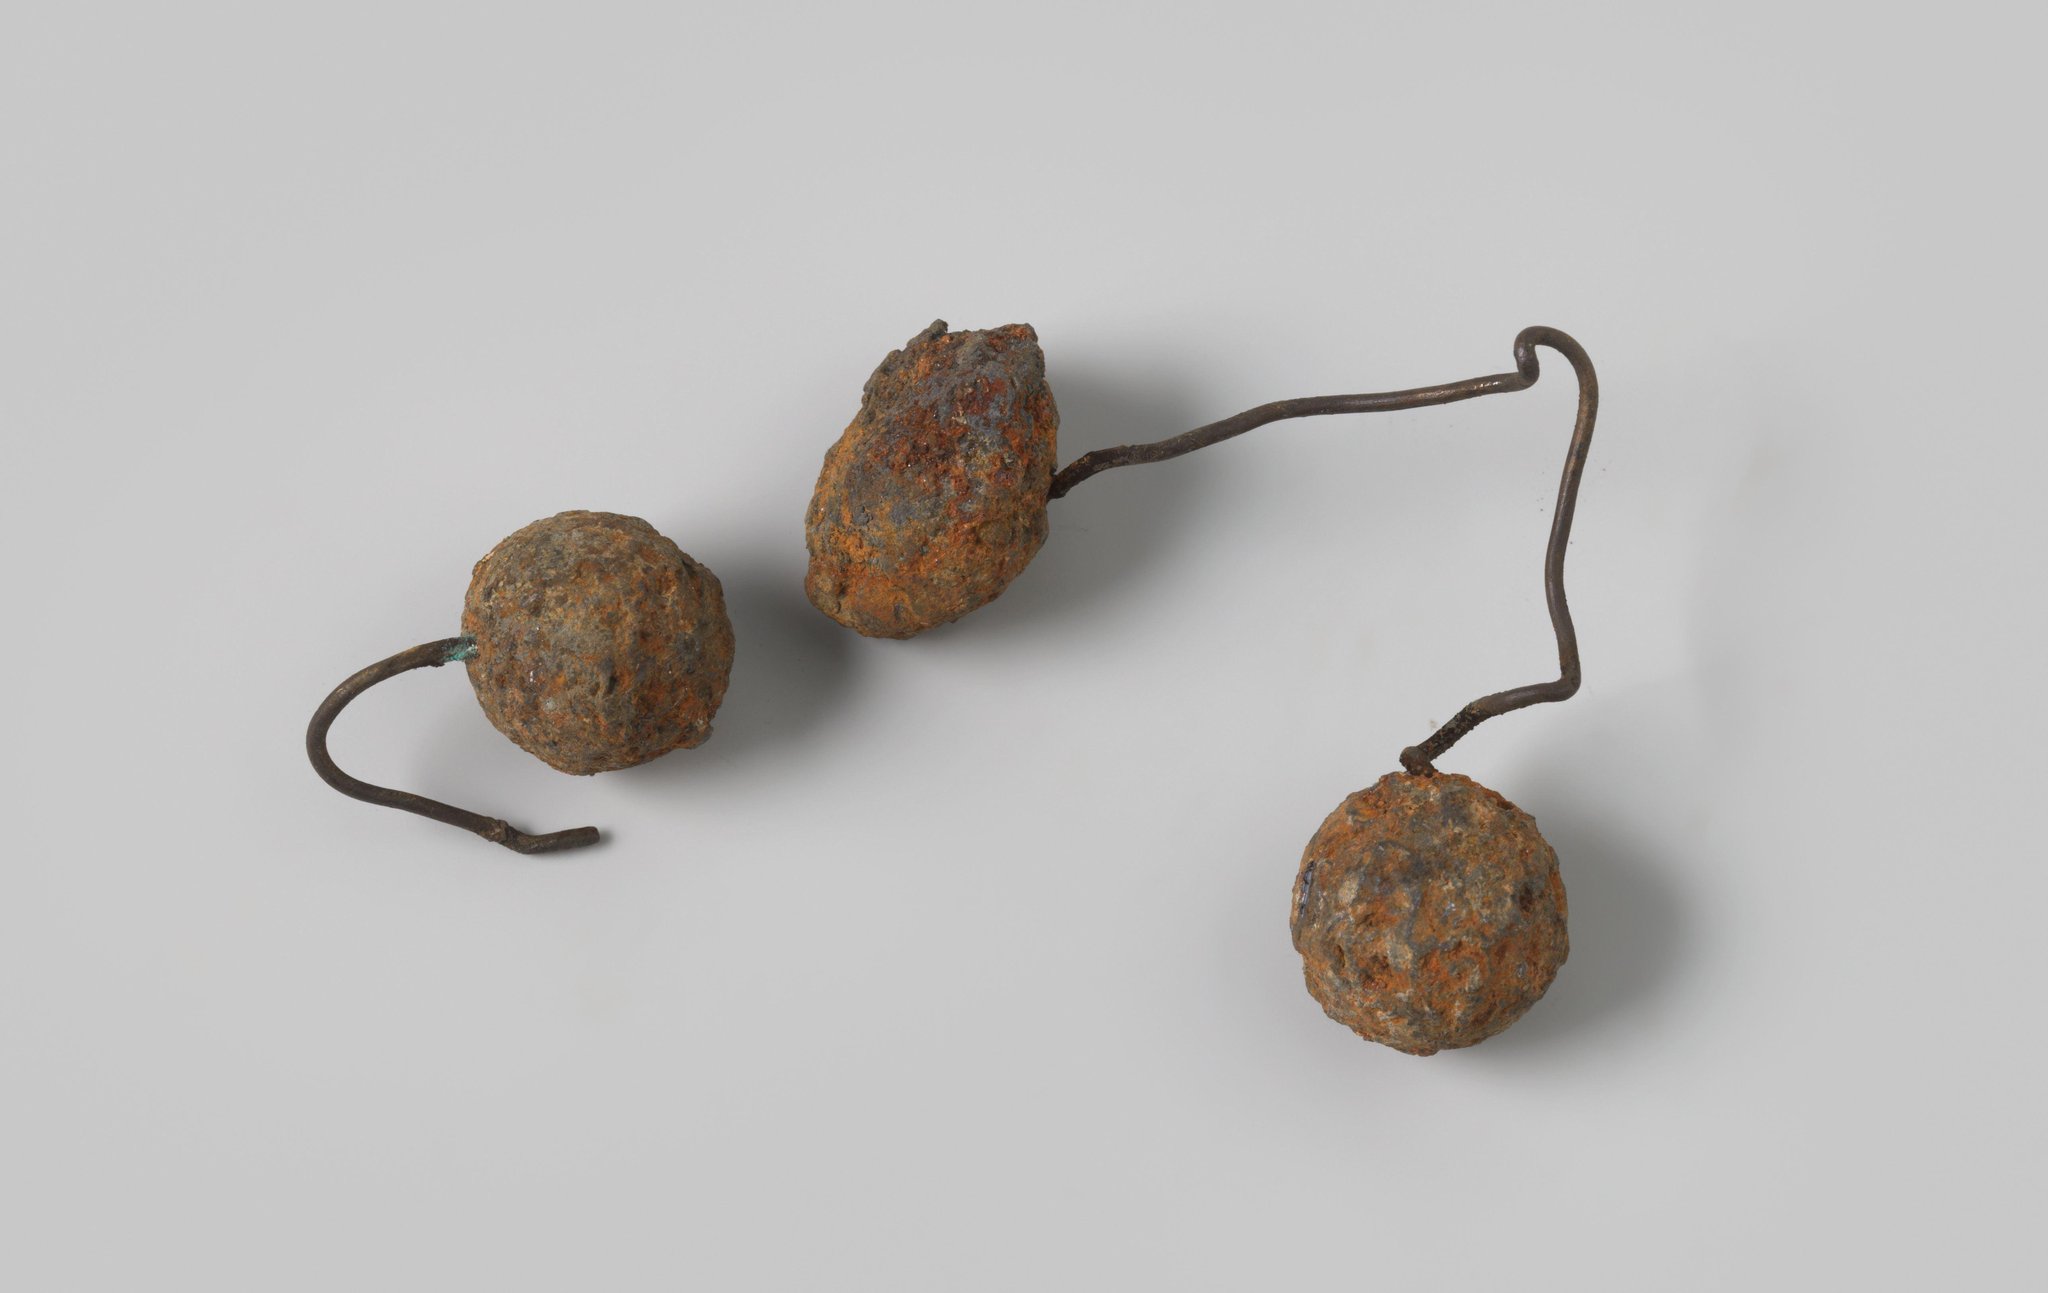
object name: chain shot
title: Kettingkogels uit het wrak van de Oost-Indiëvaarder Hollandia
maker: Anonymous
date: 1700-1743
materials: lead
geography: netherlands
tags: verenigde oostindische compagnie, hollandia (schip), annet